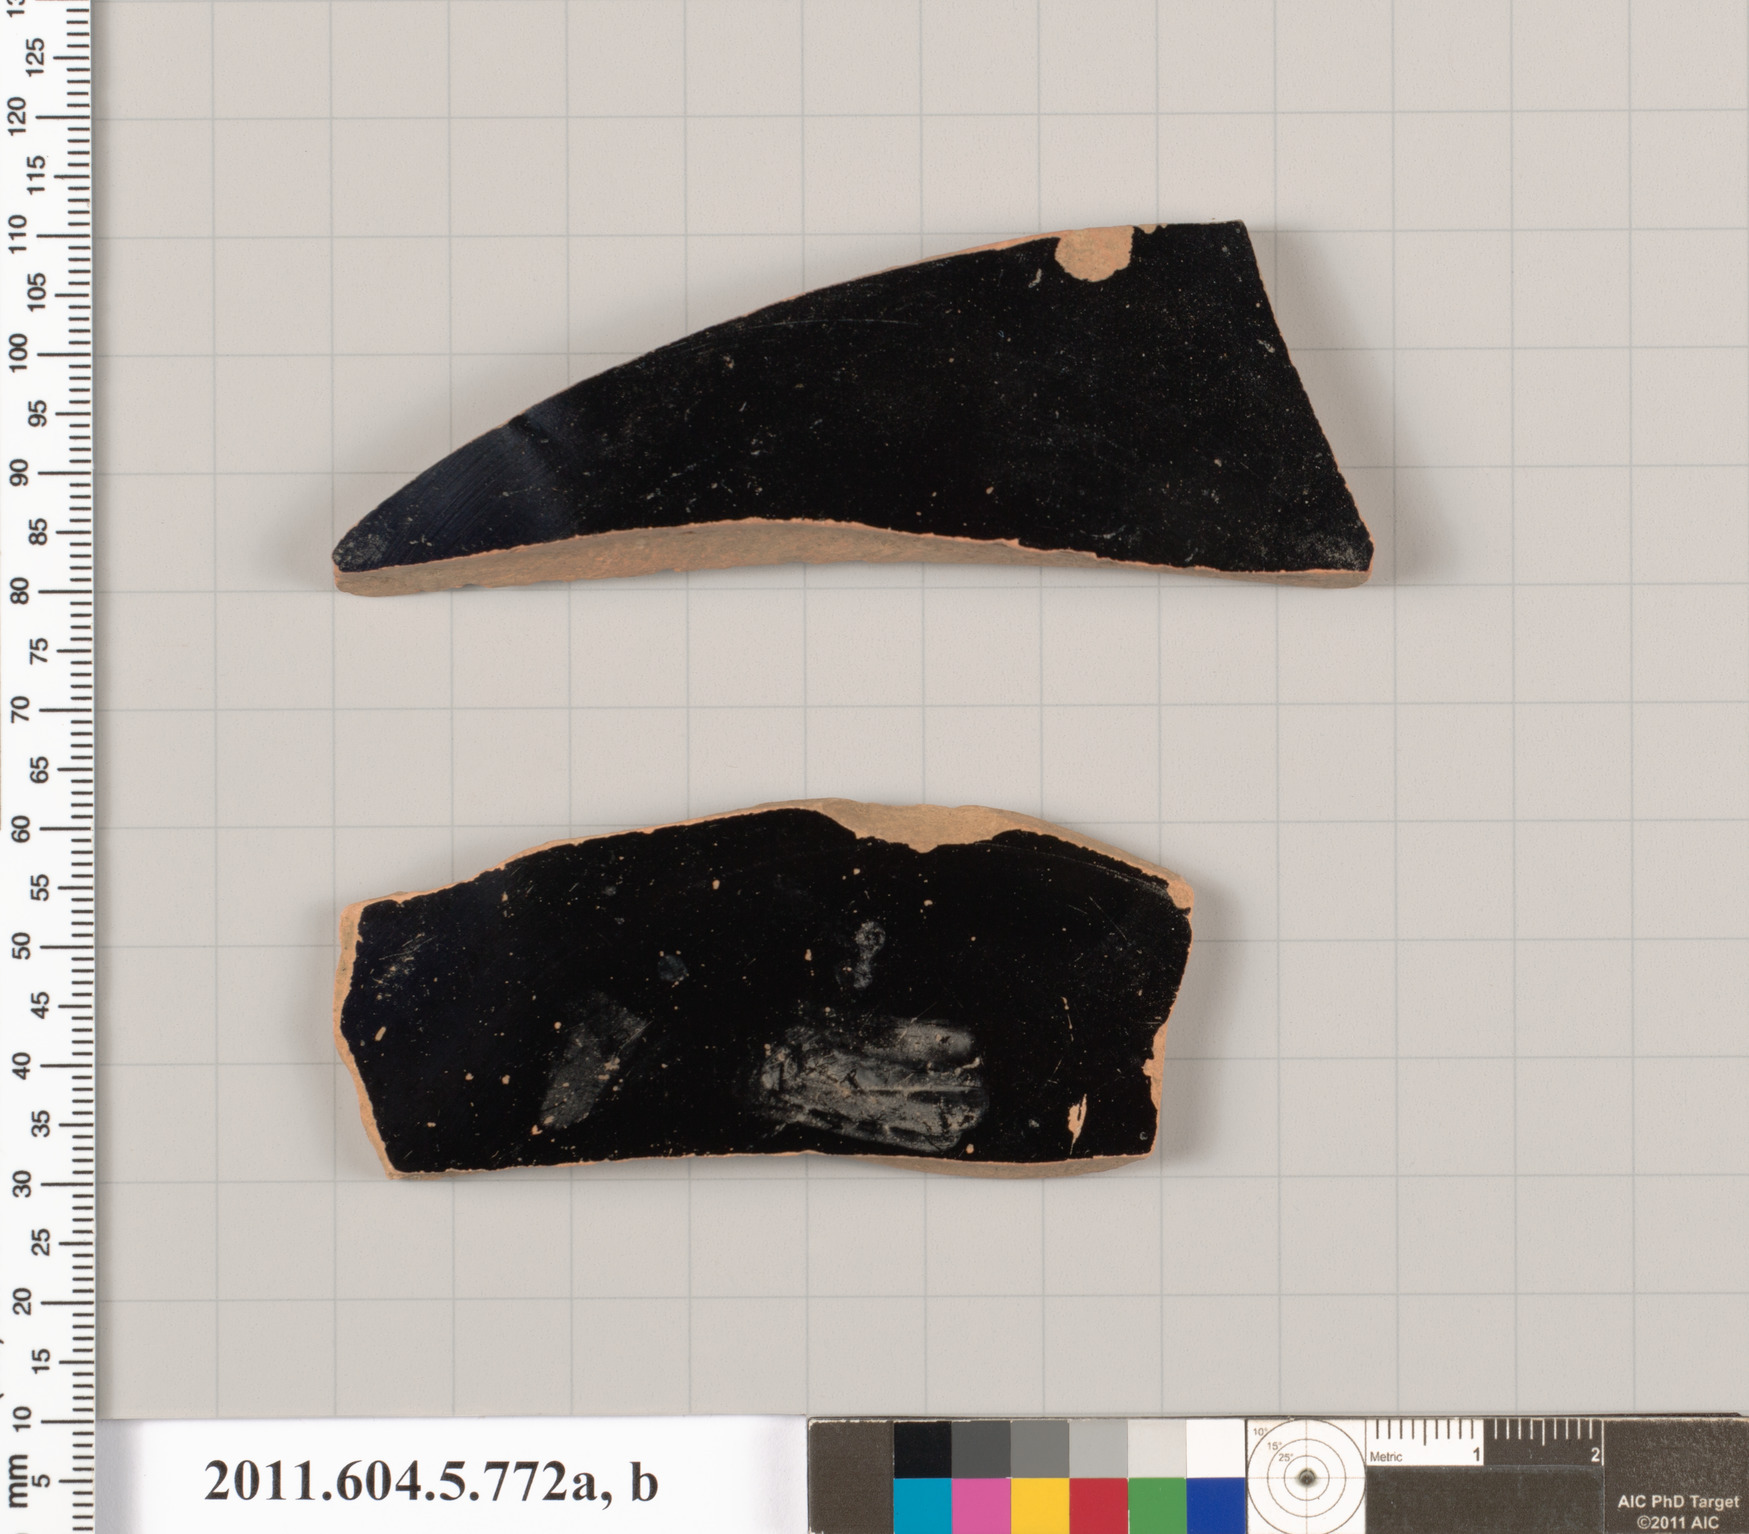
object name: kylix fragment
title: Terracotta fragments of kylikes (drinking cups)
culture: greek, attic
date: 600-401 BCE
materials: terracotta